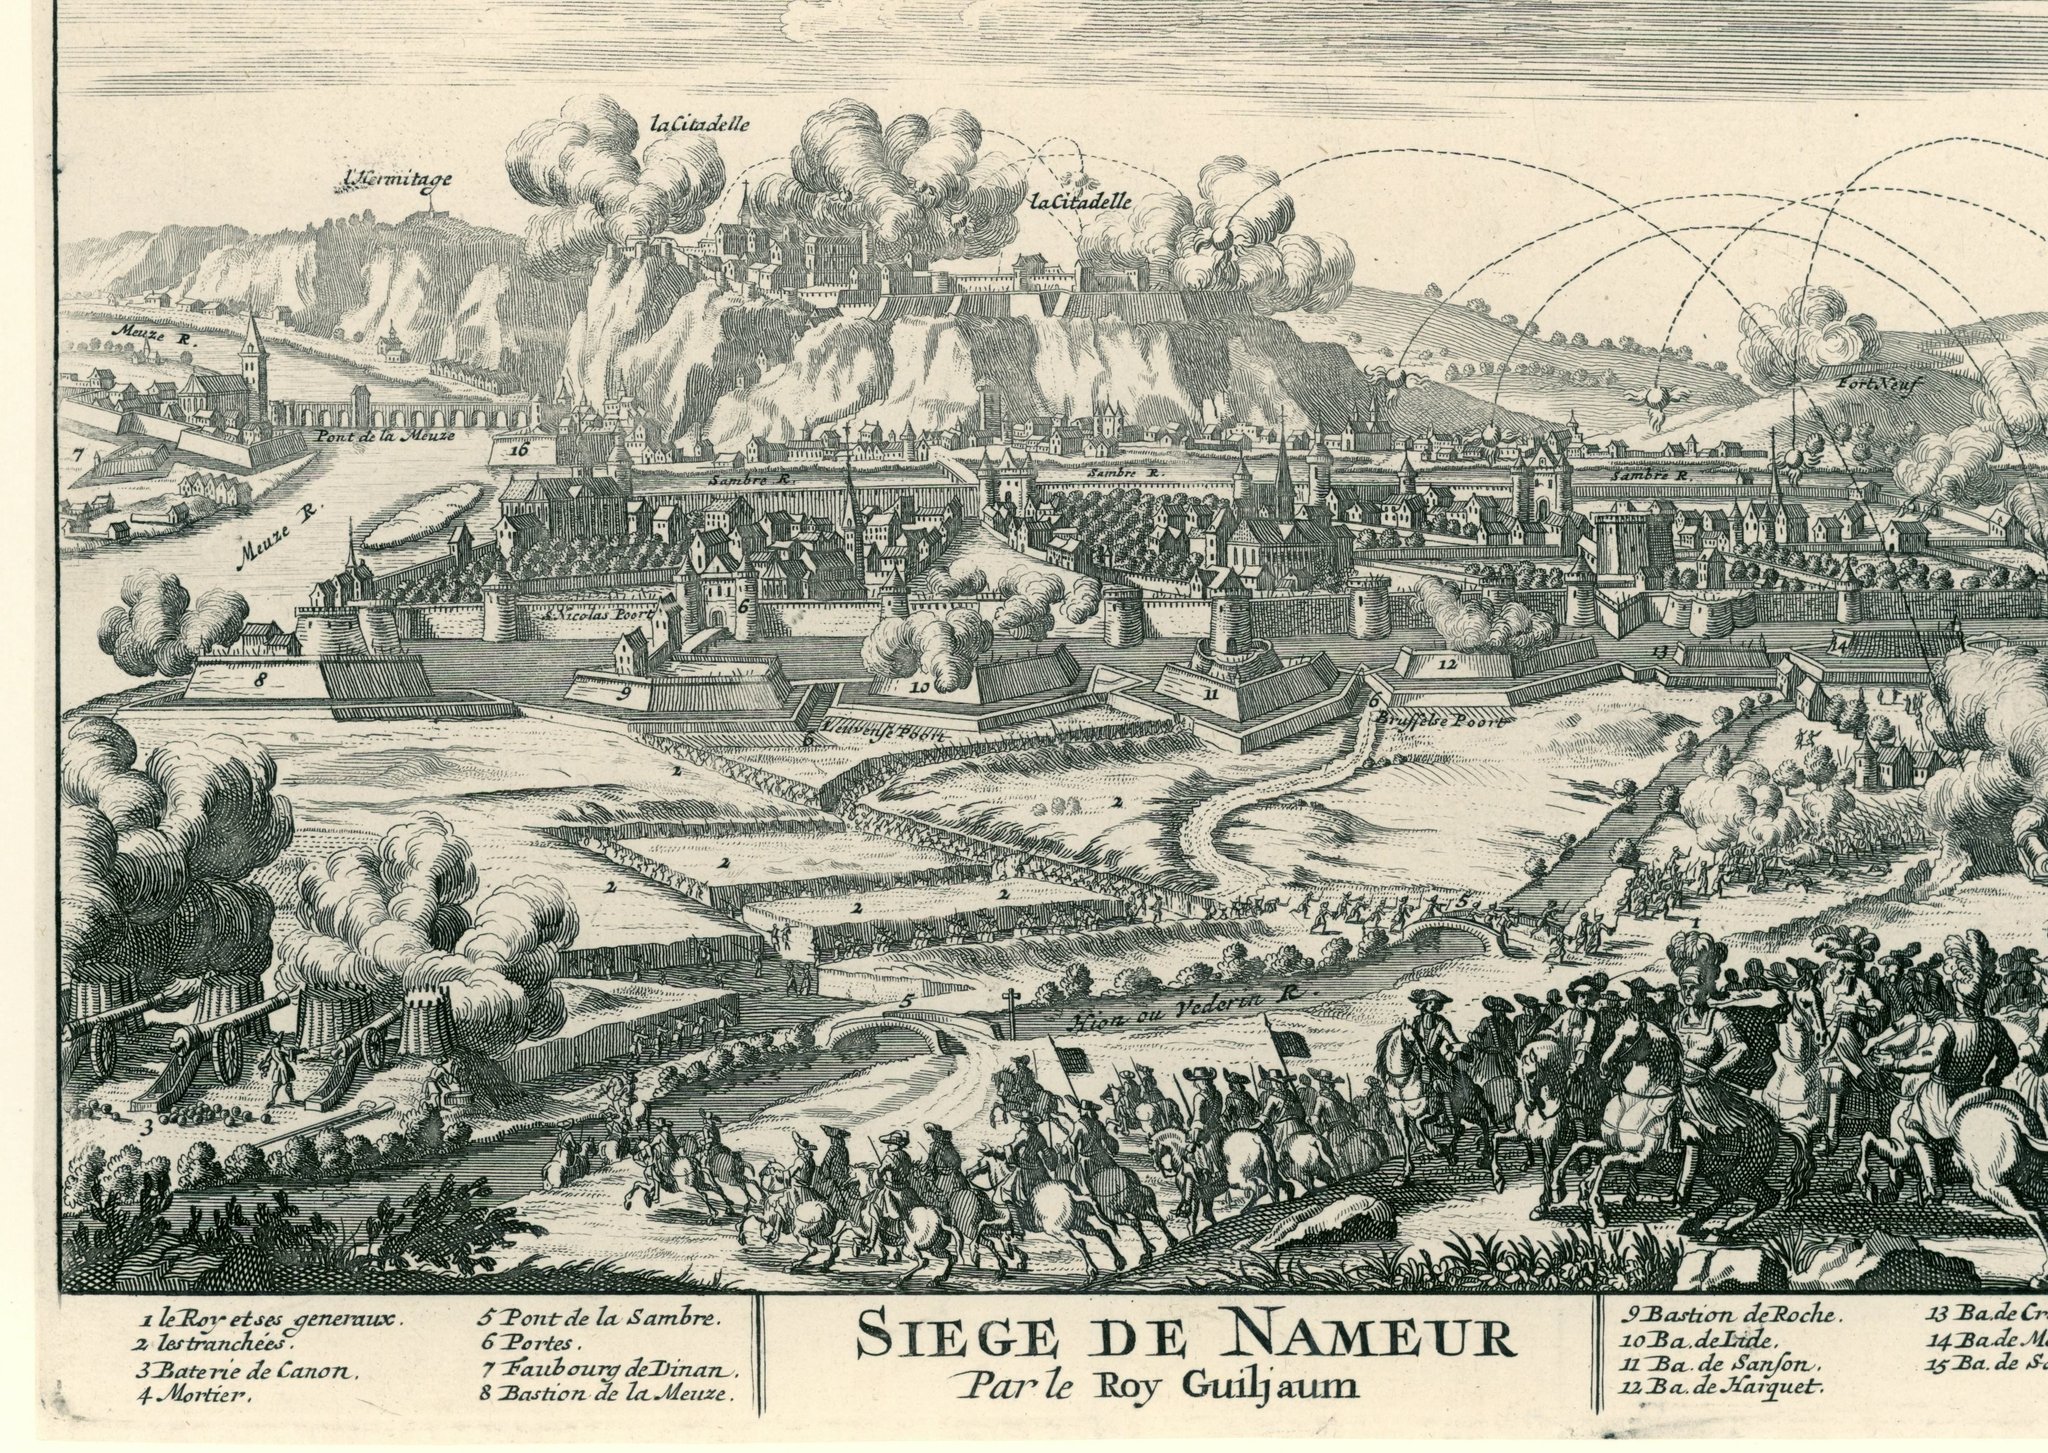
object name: history print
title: Siege de Nameur Par le Roy Guiljaum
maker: Anonymous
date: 1701-1703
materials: paper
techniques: etching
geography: northern netherlands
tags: the hague, william iii (prince of orange and king of england, scotland, and ireland), siege, position war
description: Het beleg van Namen door de geallieerden onder Willem III in 1695. De voorstelling toont de beschieting van Namen met op de voorgrond oprukkende cavalerie. Verschillende details in de voorstelling zijn met de cijfers 1-15 aangeduid en worden onderaan verklaard. In de rechter bovenhoek is een opschrift in de plaat (Tom. 3 Pag 288) gedeeltelijk verwijderd.